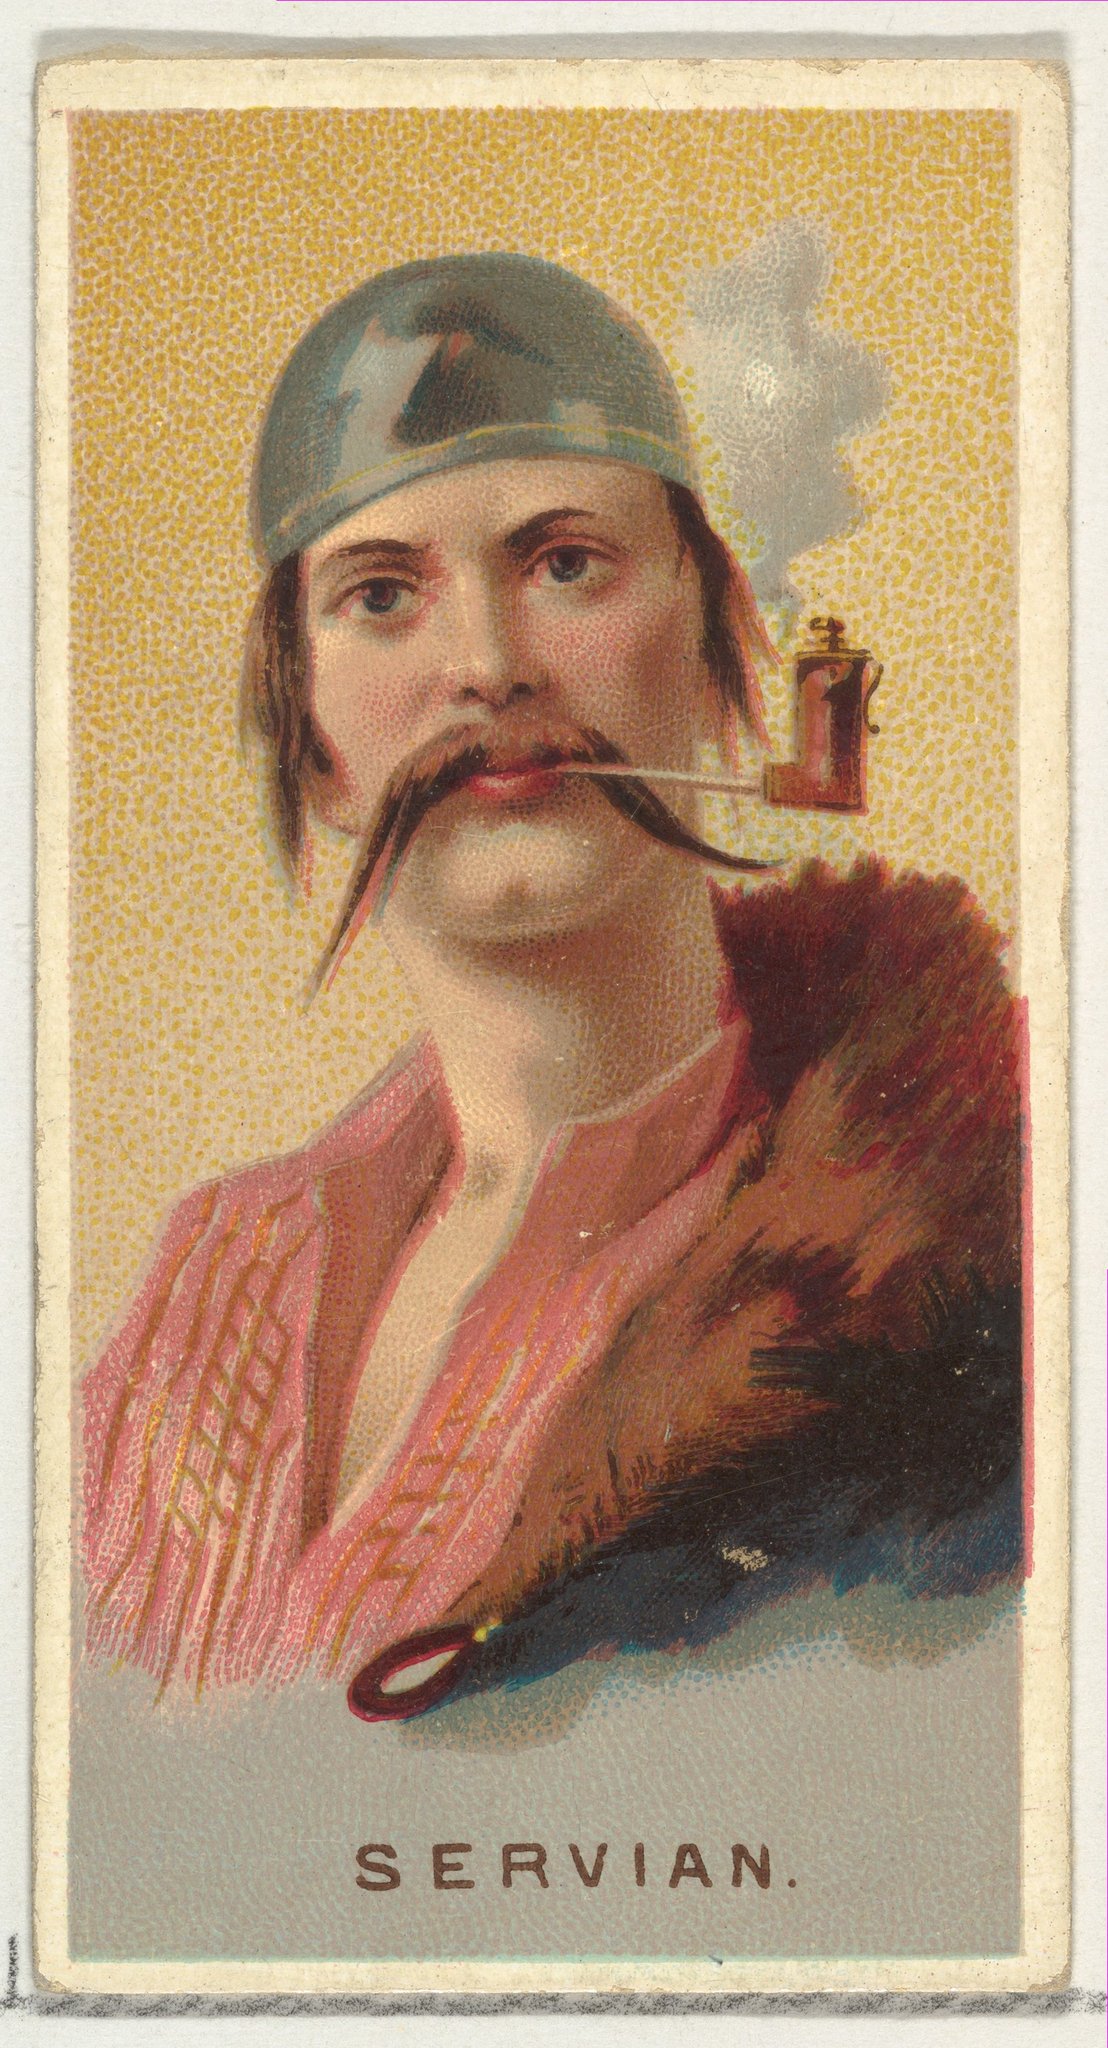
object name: print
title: Serbian, from World's Smokers series (N33) for Allen & Ginter Cigarettes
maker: allen & ginter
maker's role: publisher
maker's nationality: american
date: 1888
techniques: color lithograph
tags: men,smoking